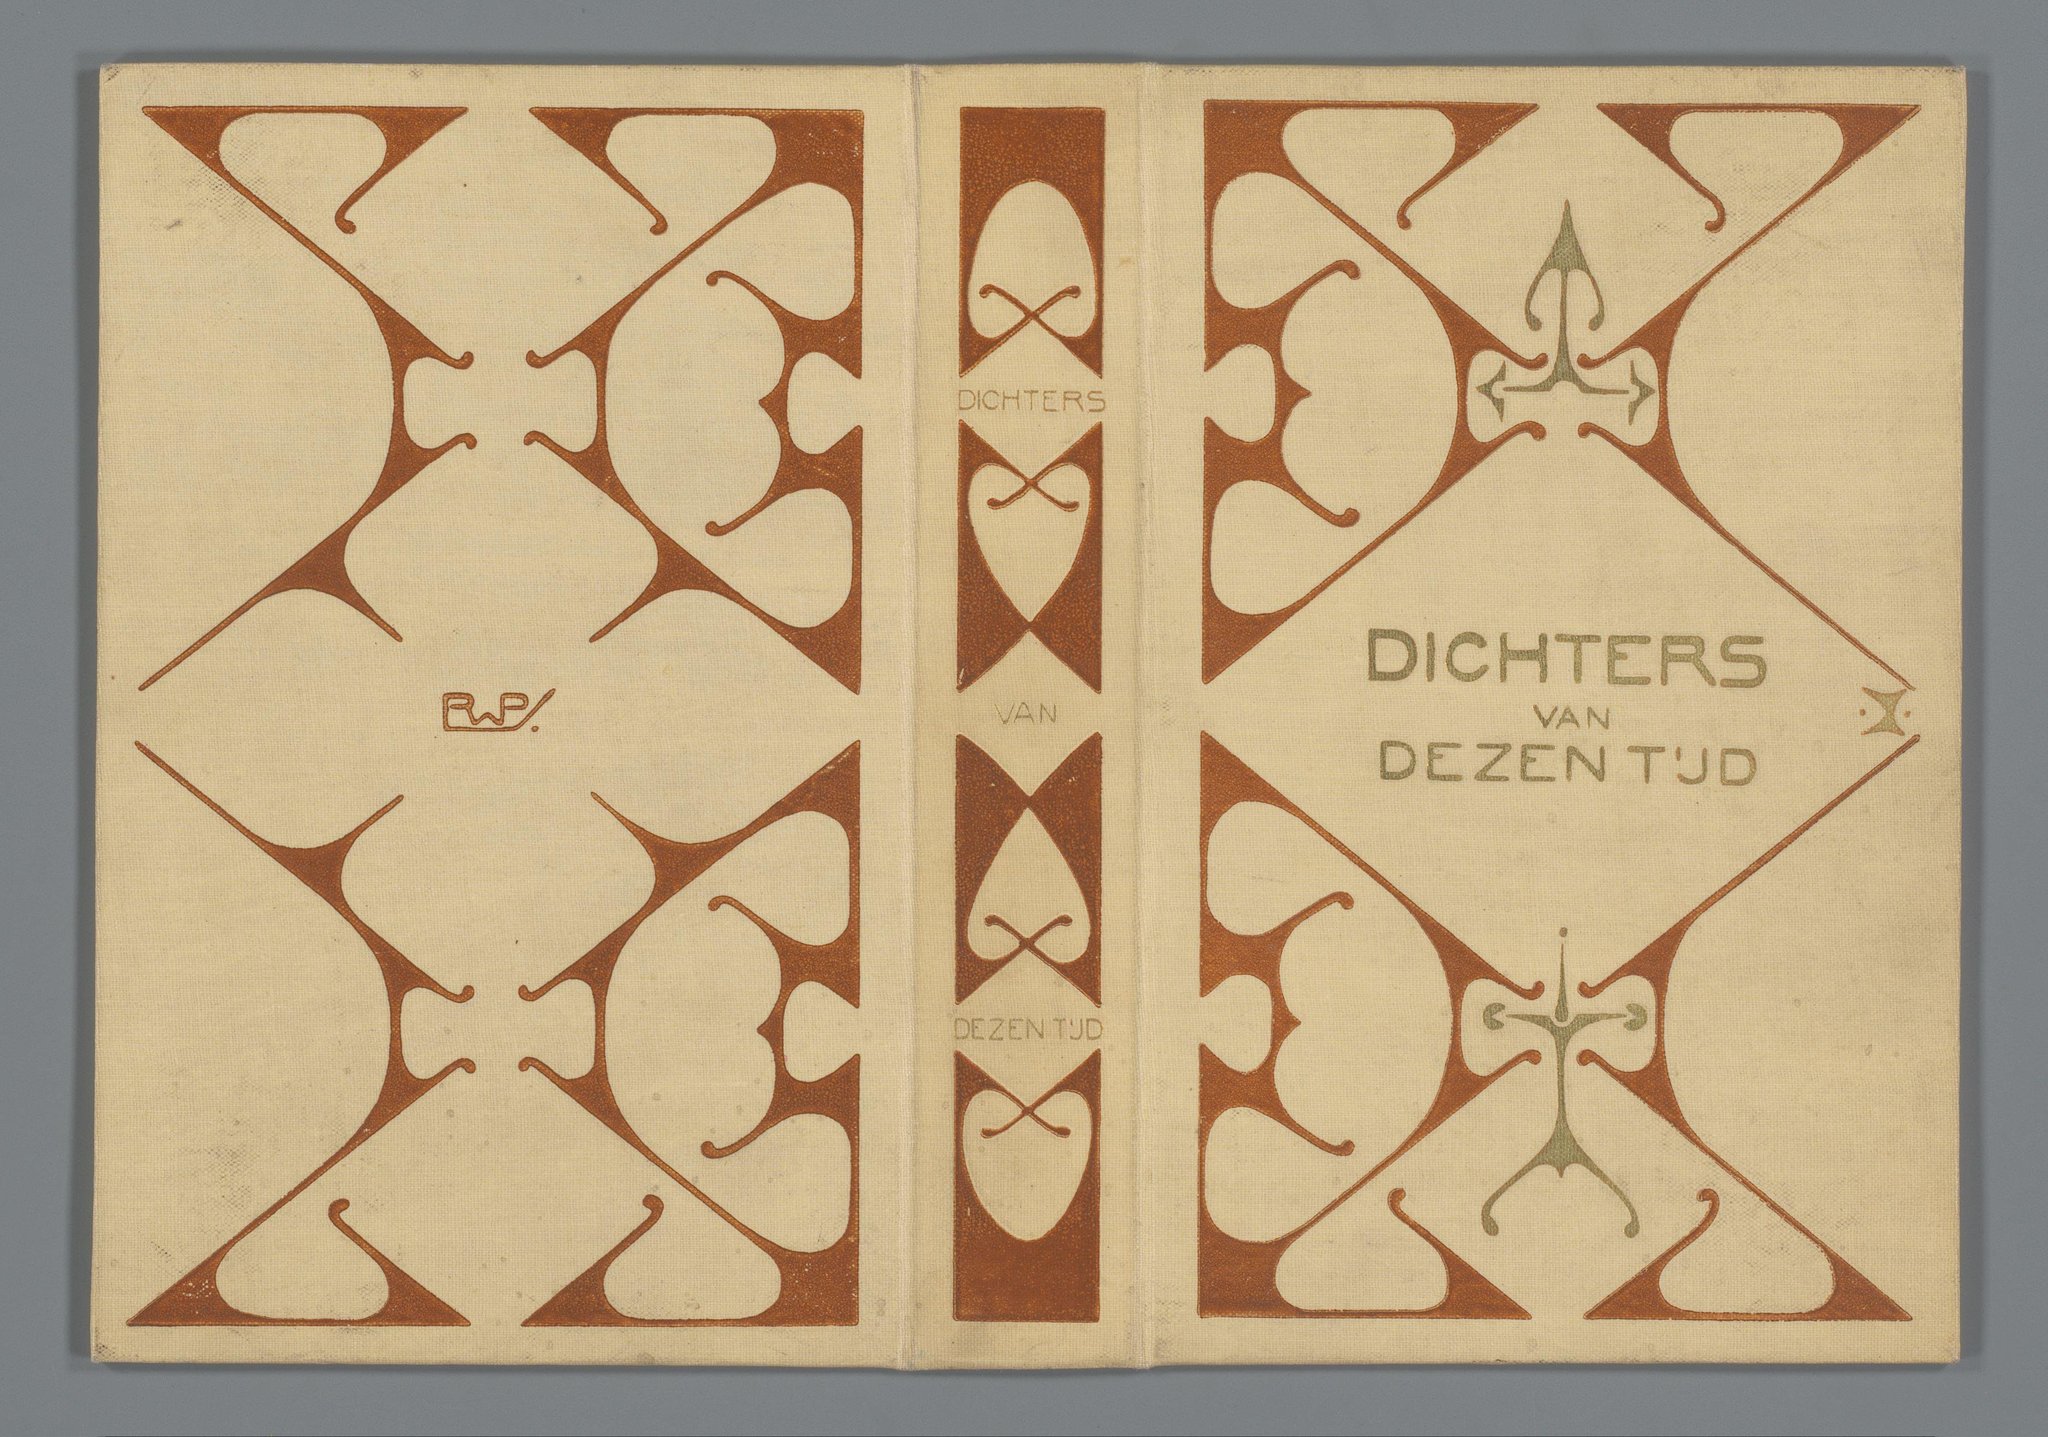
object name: binding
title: Boekband voor: J.N. van Hall, Dichters van deze tijd, 1899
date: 1899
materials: cardboard, linen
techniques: printing block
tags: ornaments ~ art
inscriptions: number: ‘4.’, collector's mark: ‘R:MVS.’, name: ‘D.G. van Bommel/ Boekbinder.’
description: Boekband voor: Hall, J.N. van. Dichters van deze tijd. Amsterdam: Van Kampen, 1899.